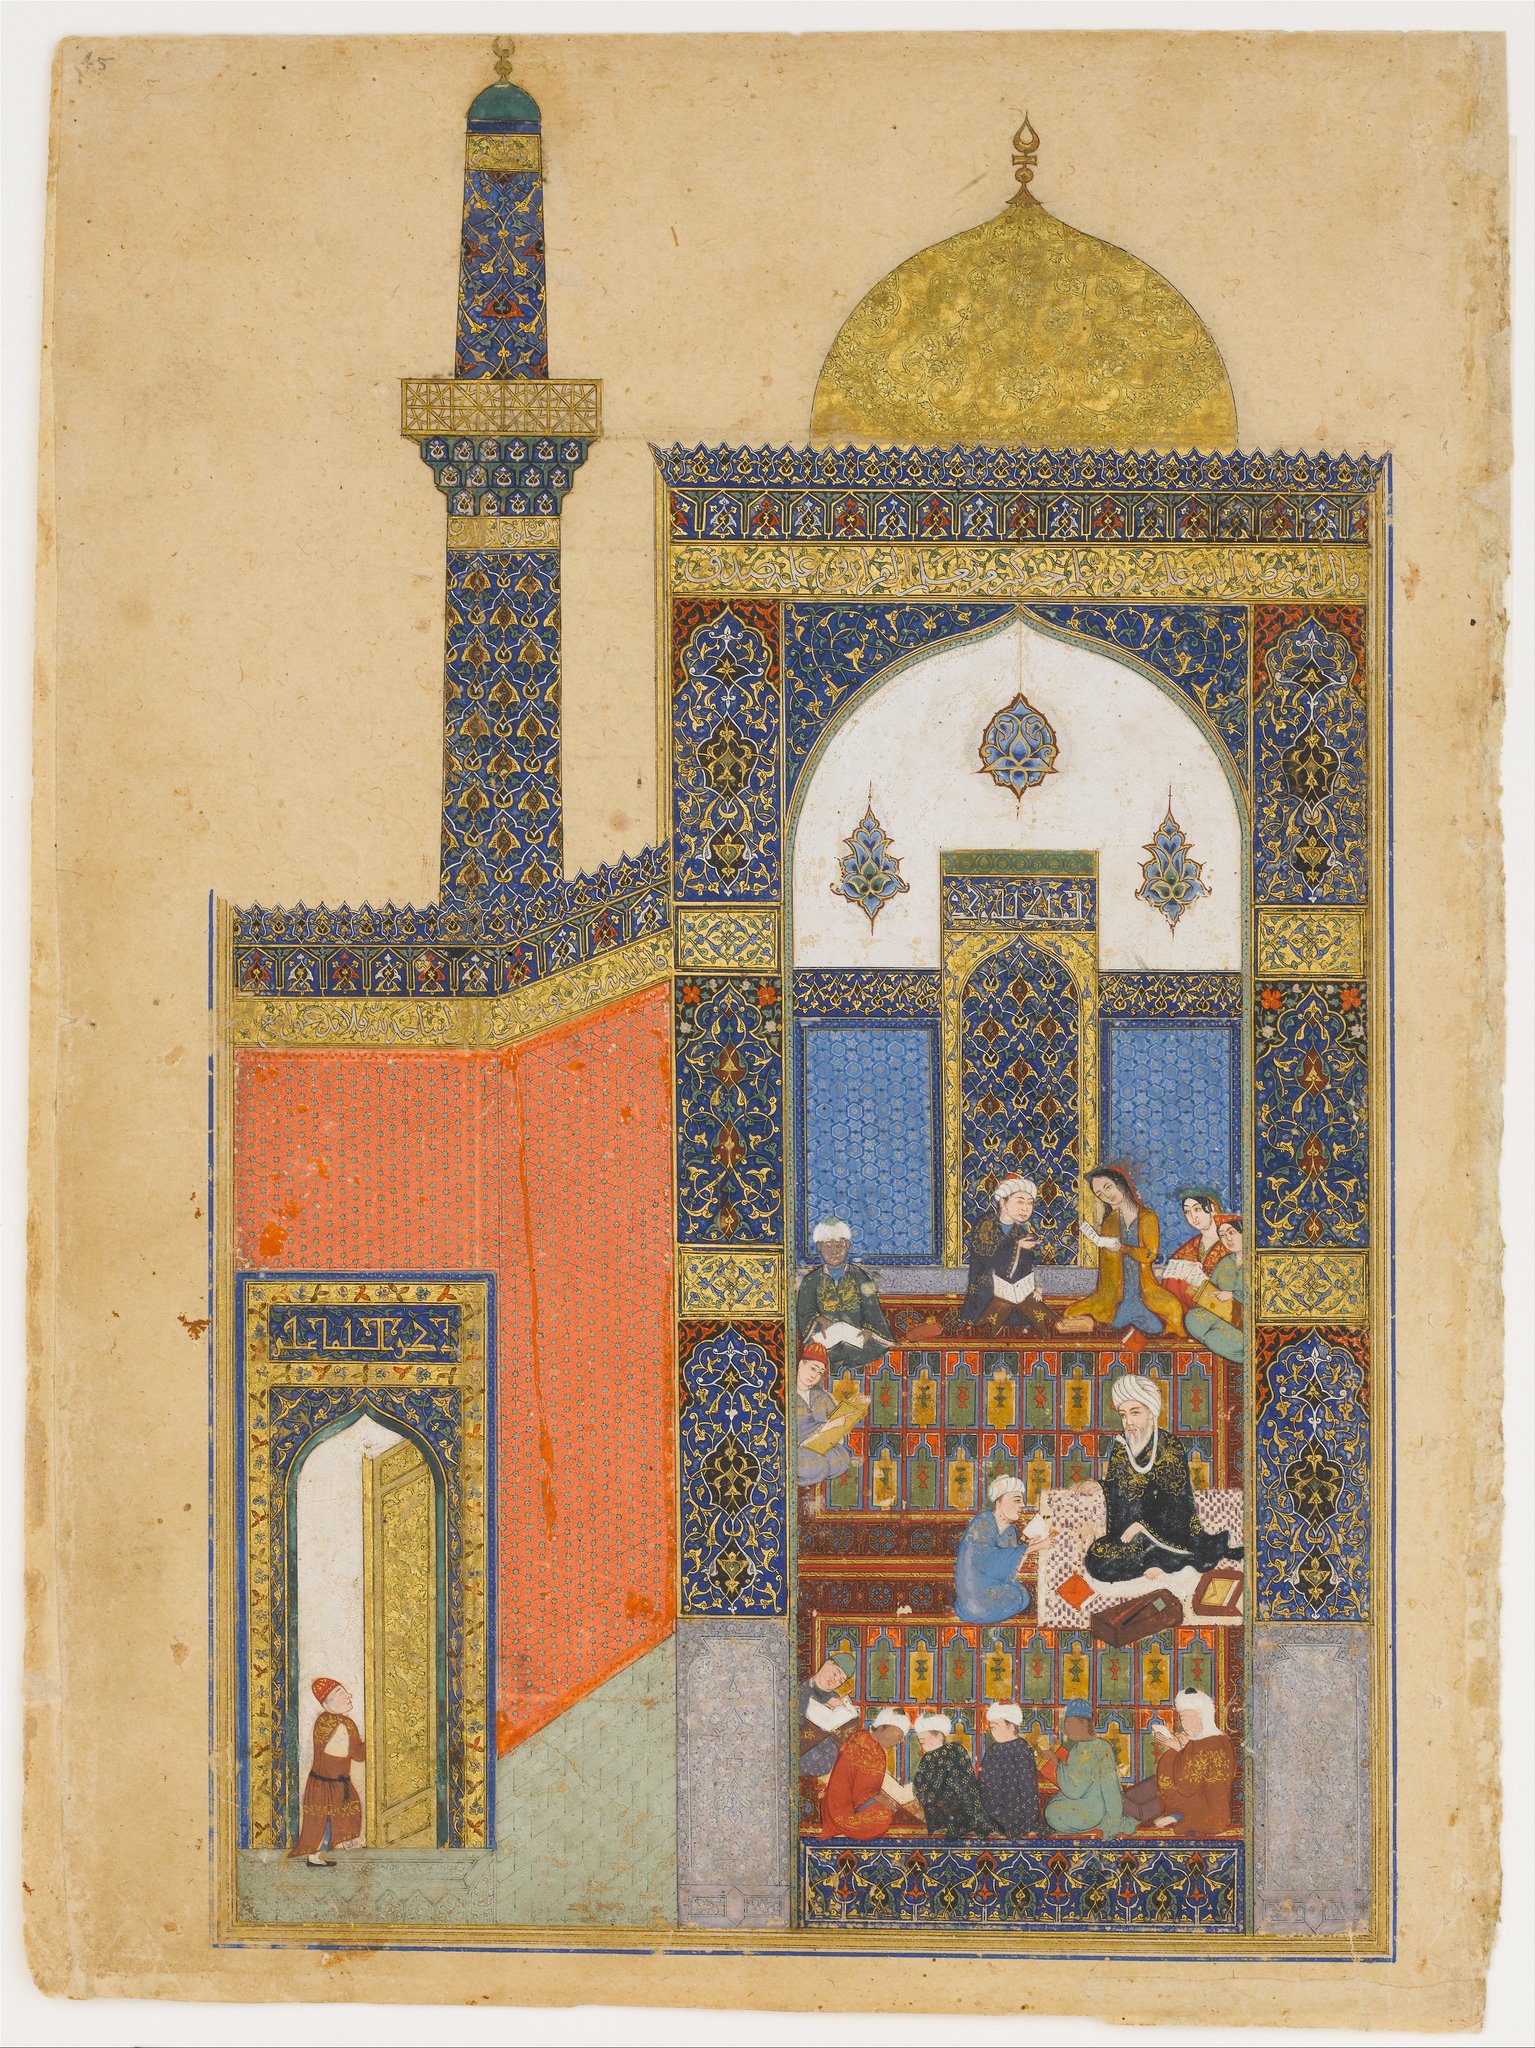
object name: folio from an illustrated manuscript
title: "Laila and Majnun at School", Folio from a Khamsa (Quintet) of Nizami of Ganja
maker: ja'far baisunghuri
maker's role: calligrapher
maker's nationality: iranian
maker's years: 1400-1460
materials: gold, ink, paper, watercolor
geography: afghanistan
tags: schools,boys,girls,men,reading,students,teachers